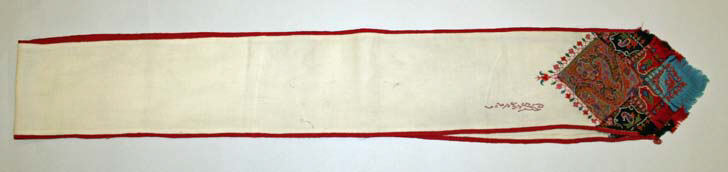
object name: scarf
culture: american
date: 1890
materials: wool